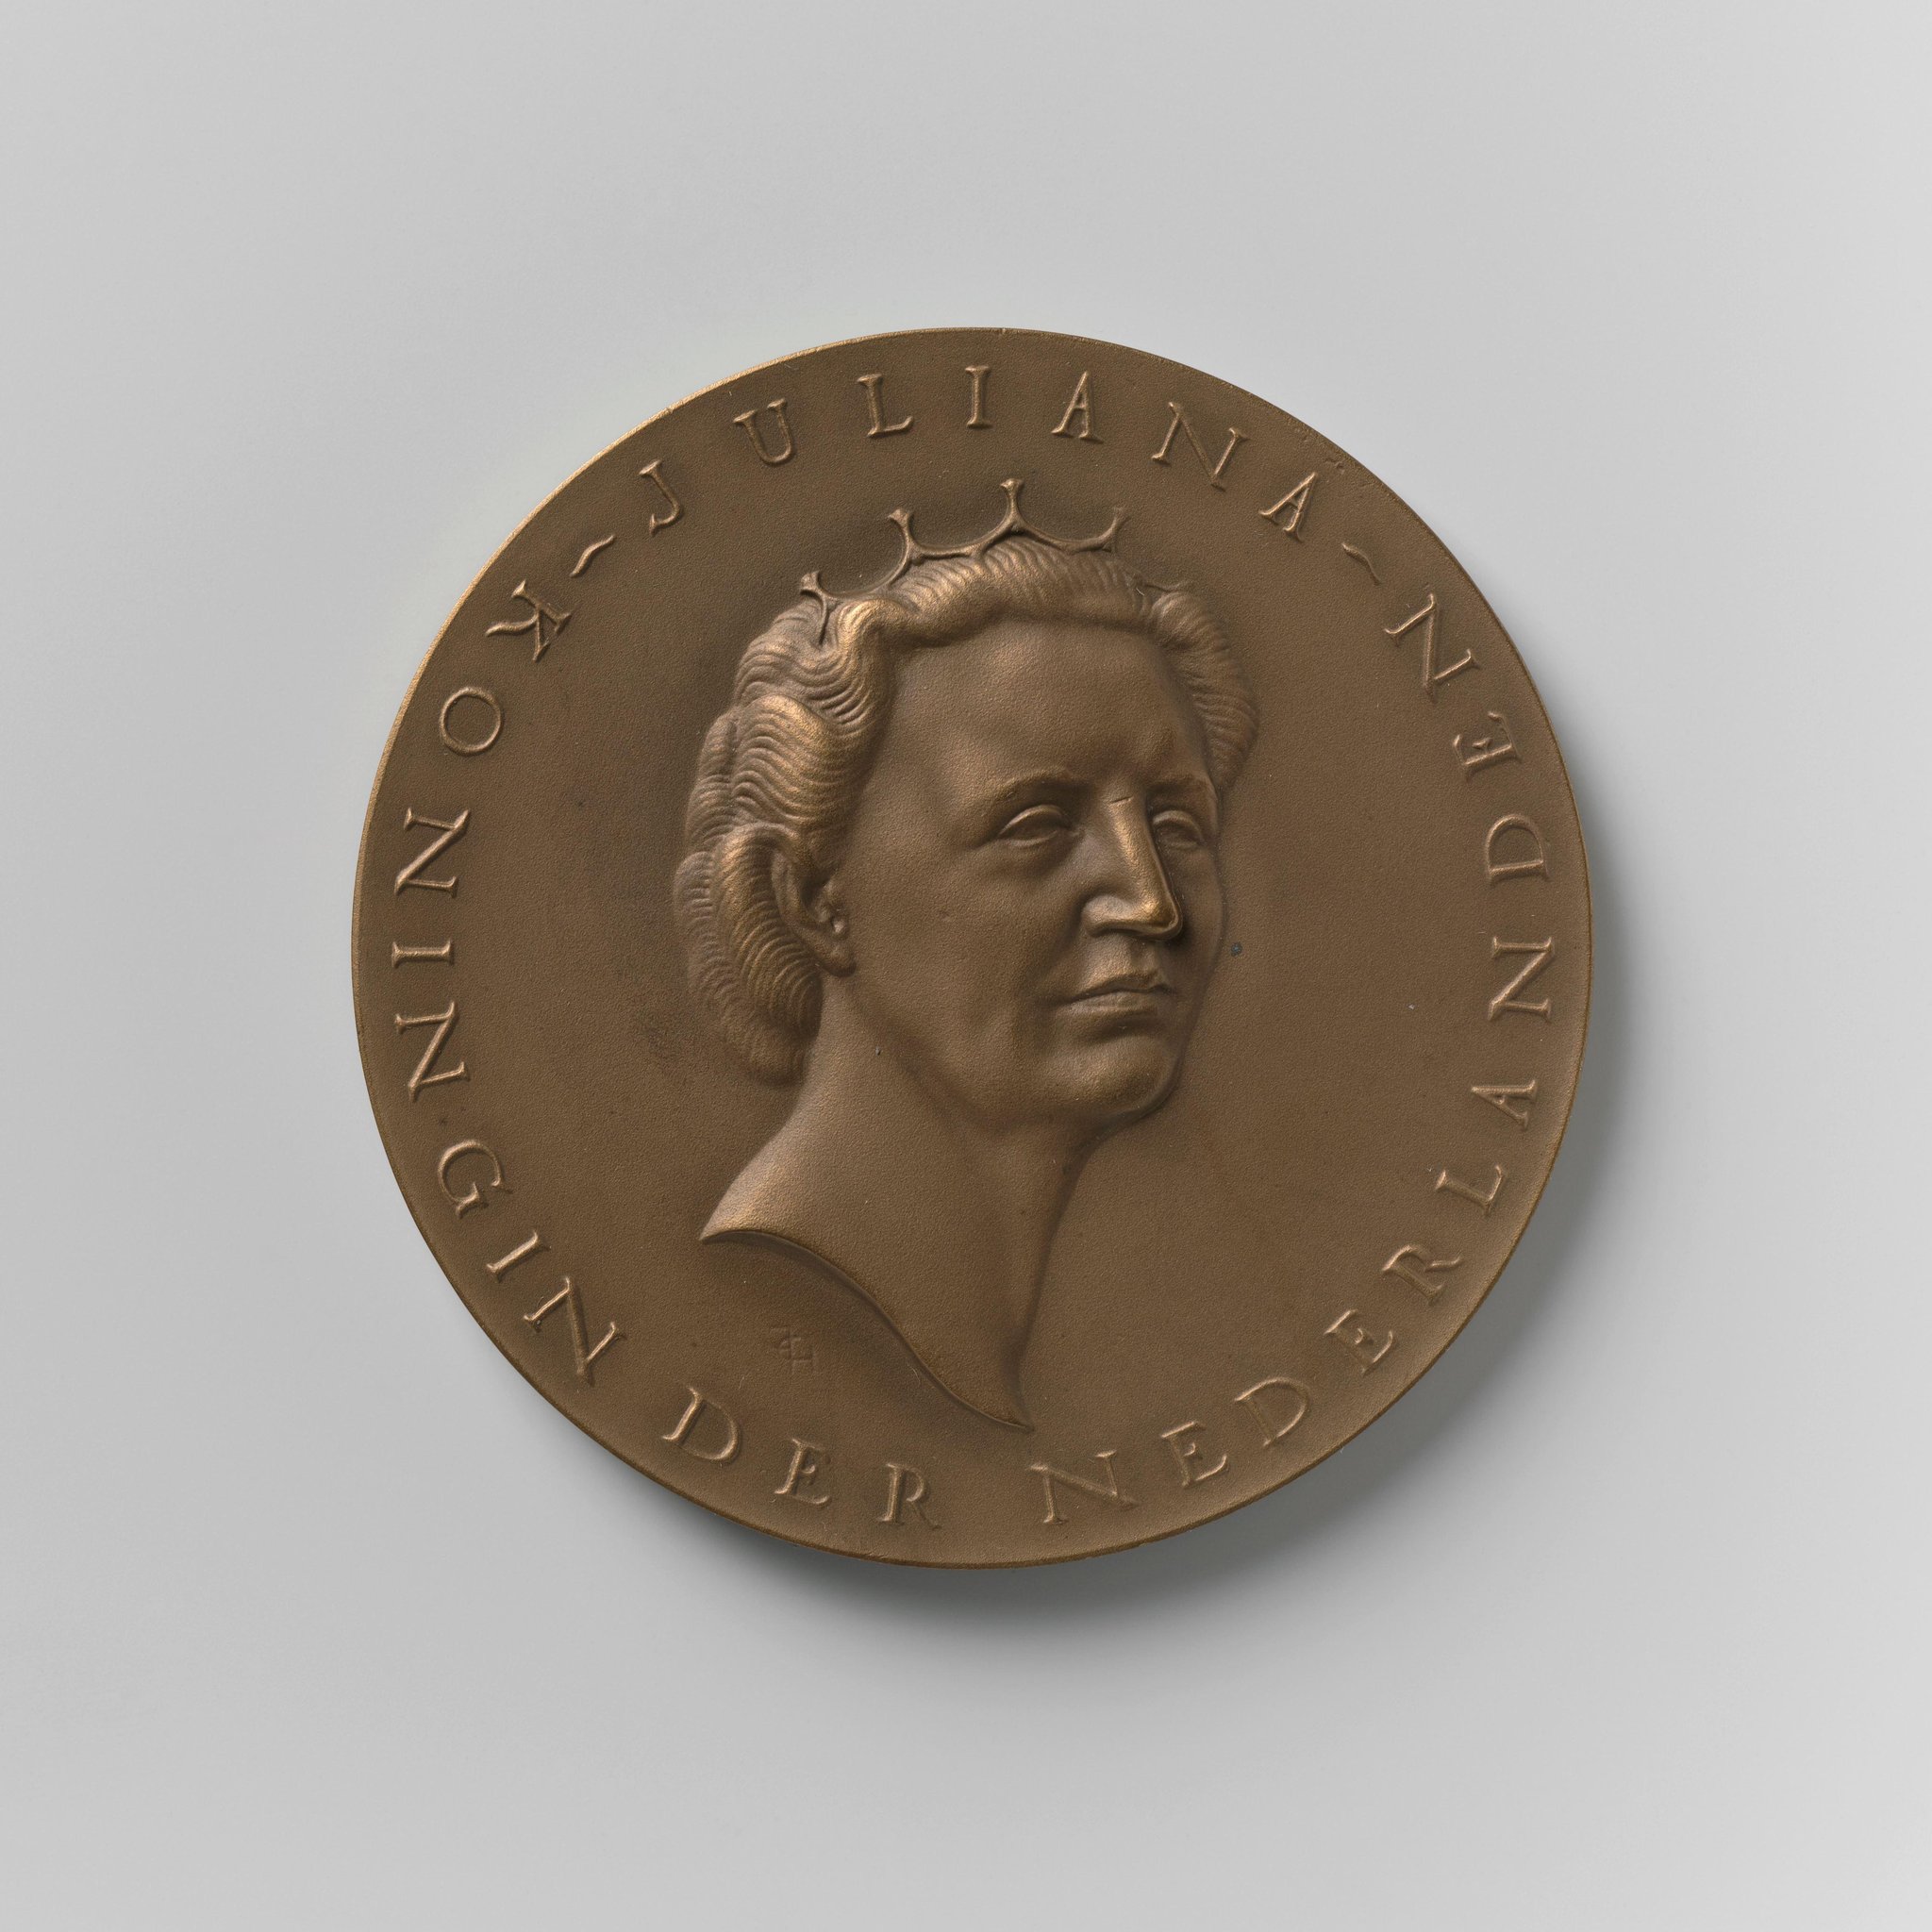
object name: history medal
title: Inhuldiging van Koningin Juliana te Amsterdam 1948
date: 1948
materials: bronze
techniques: striking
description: Bronzen penning, op de voorzijde he portret van Juliana half naar rechts met omschrift, op de keerzijde de Nederlandse Maagd met leeuw op een koningskroon waaronder een tekstlint, met omschrift.